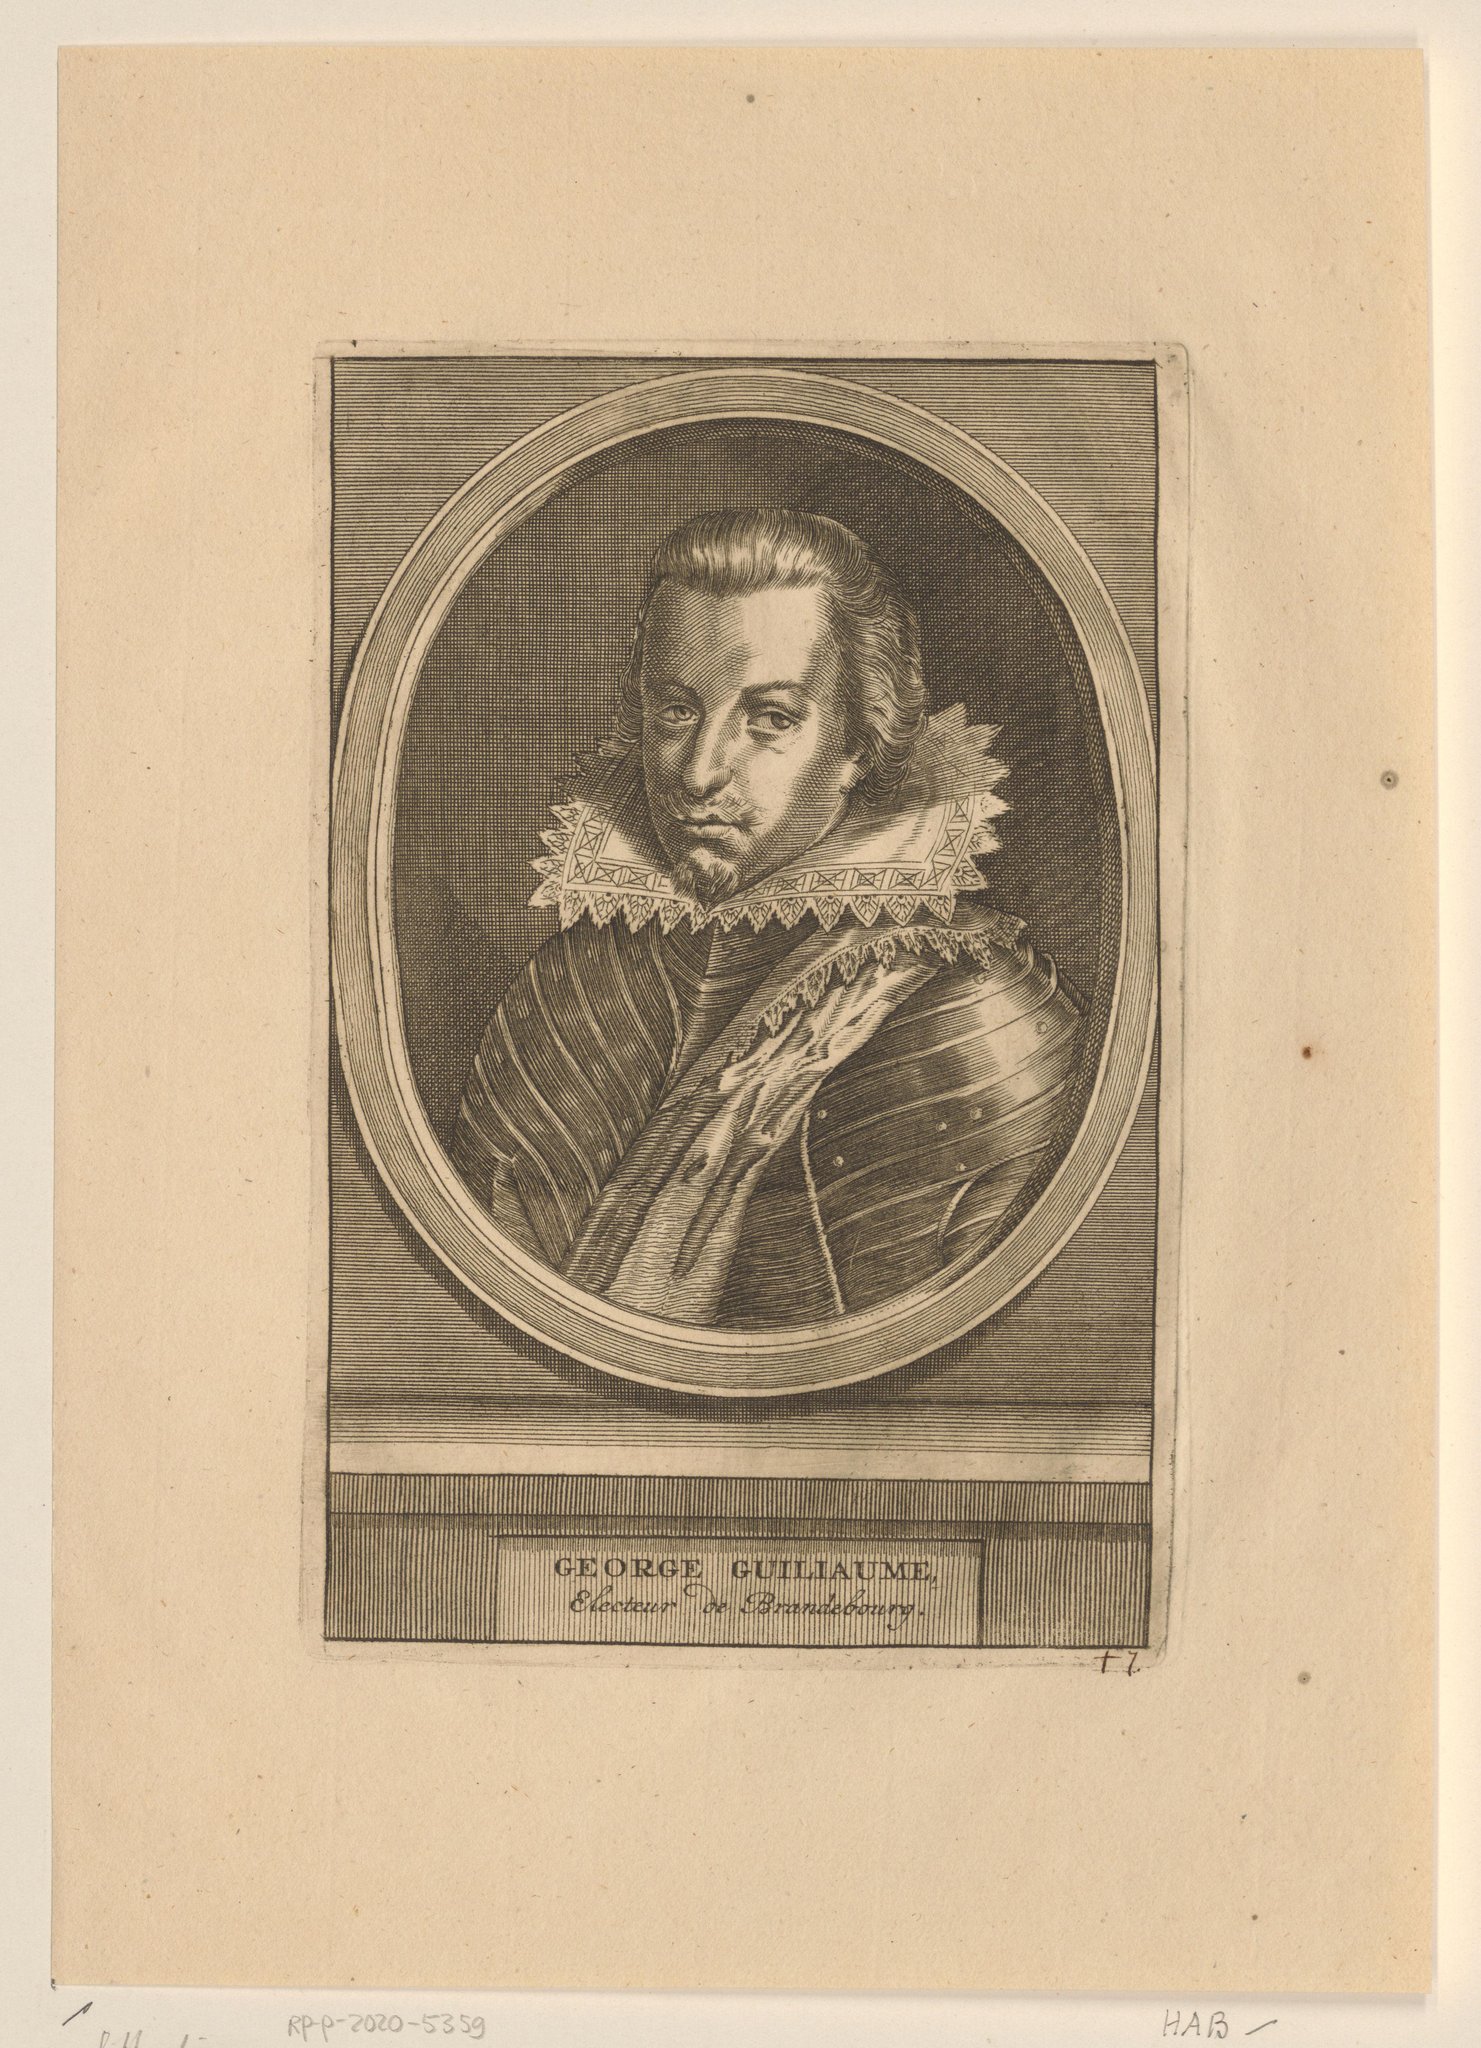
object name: print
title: Portret van Georg Wilhelm van Brandenburg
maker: Anonymous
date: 1620-1720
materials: paper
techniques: engraving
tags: historical persons